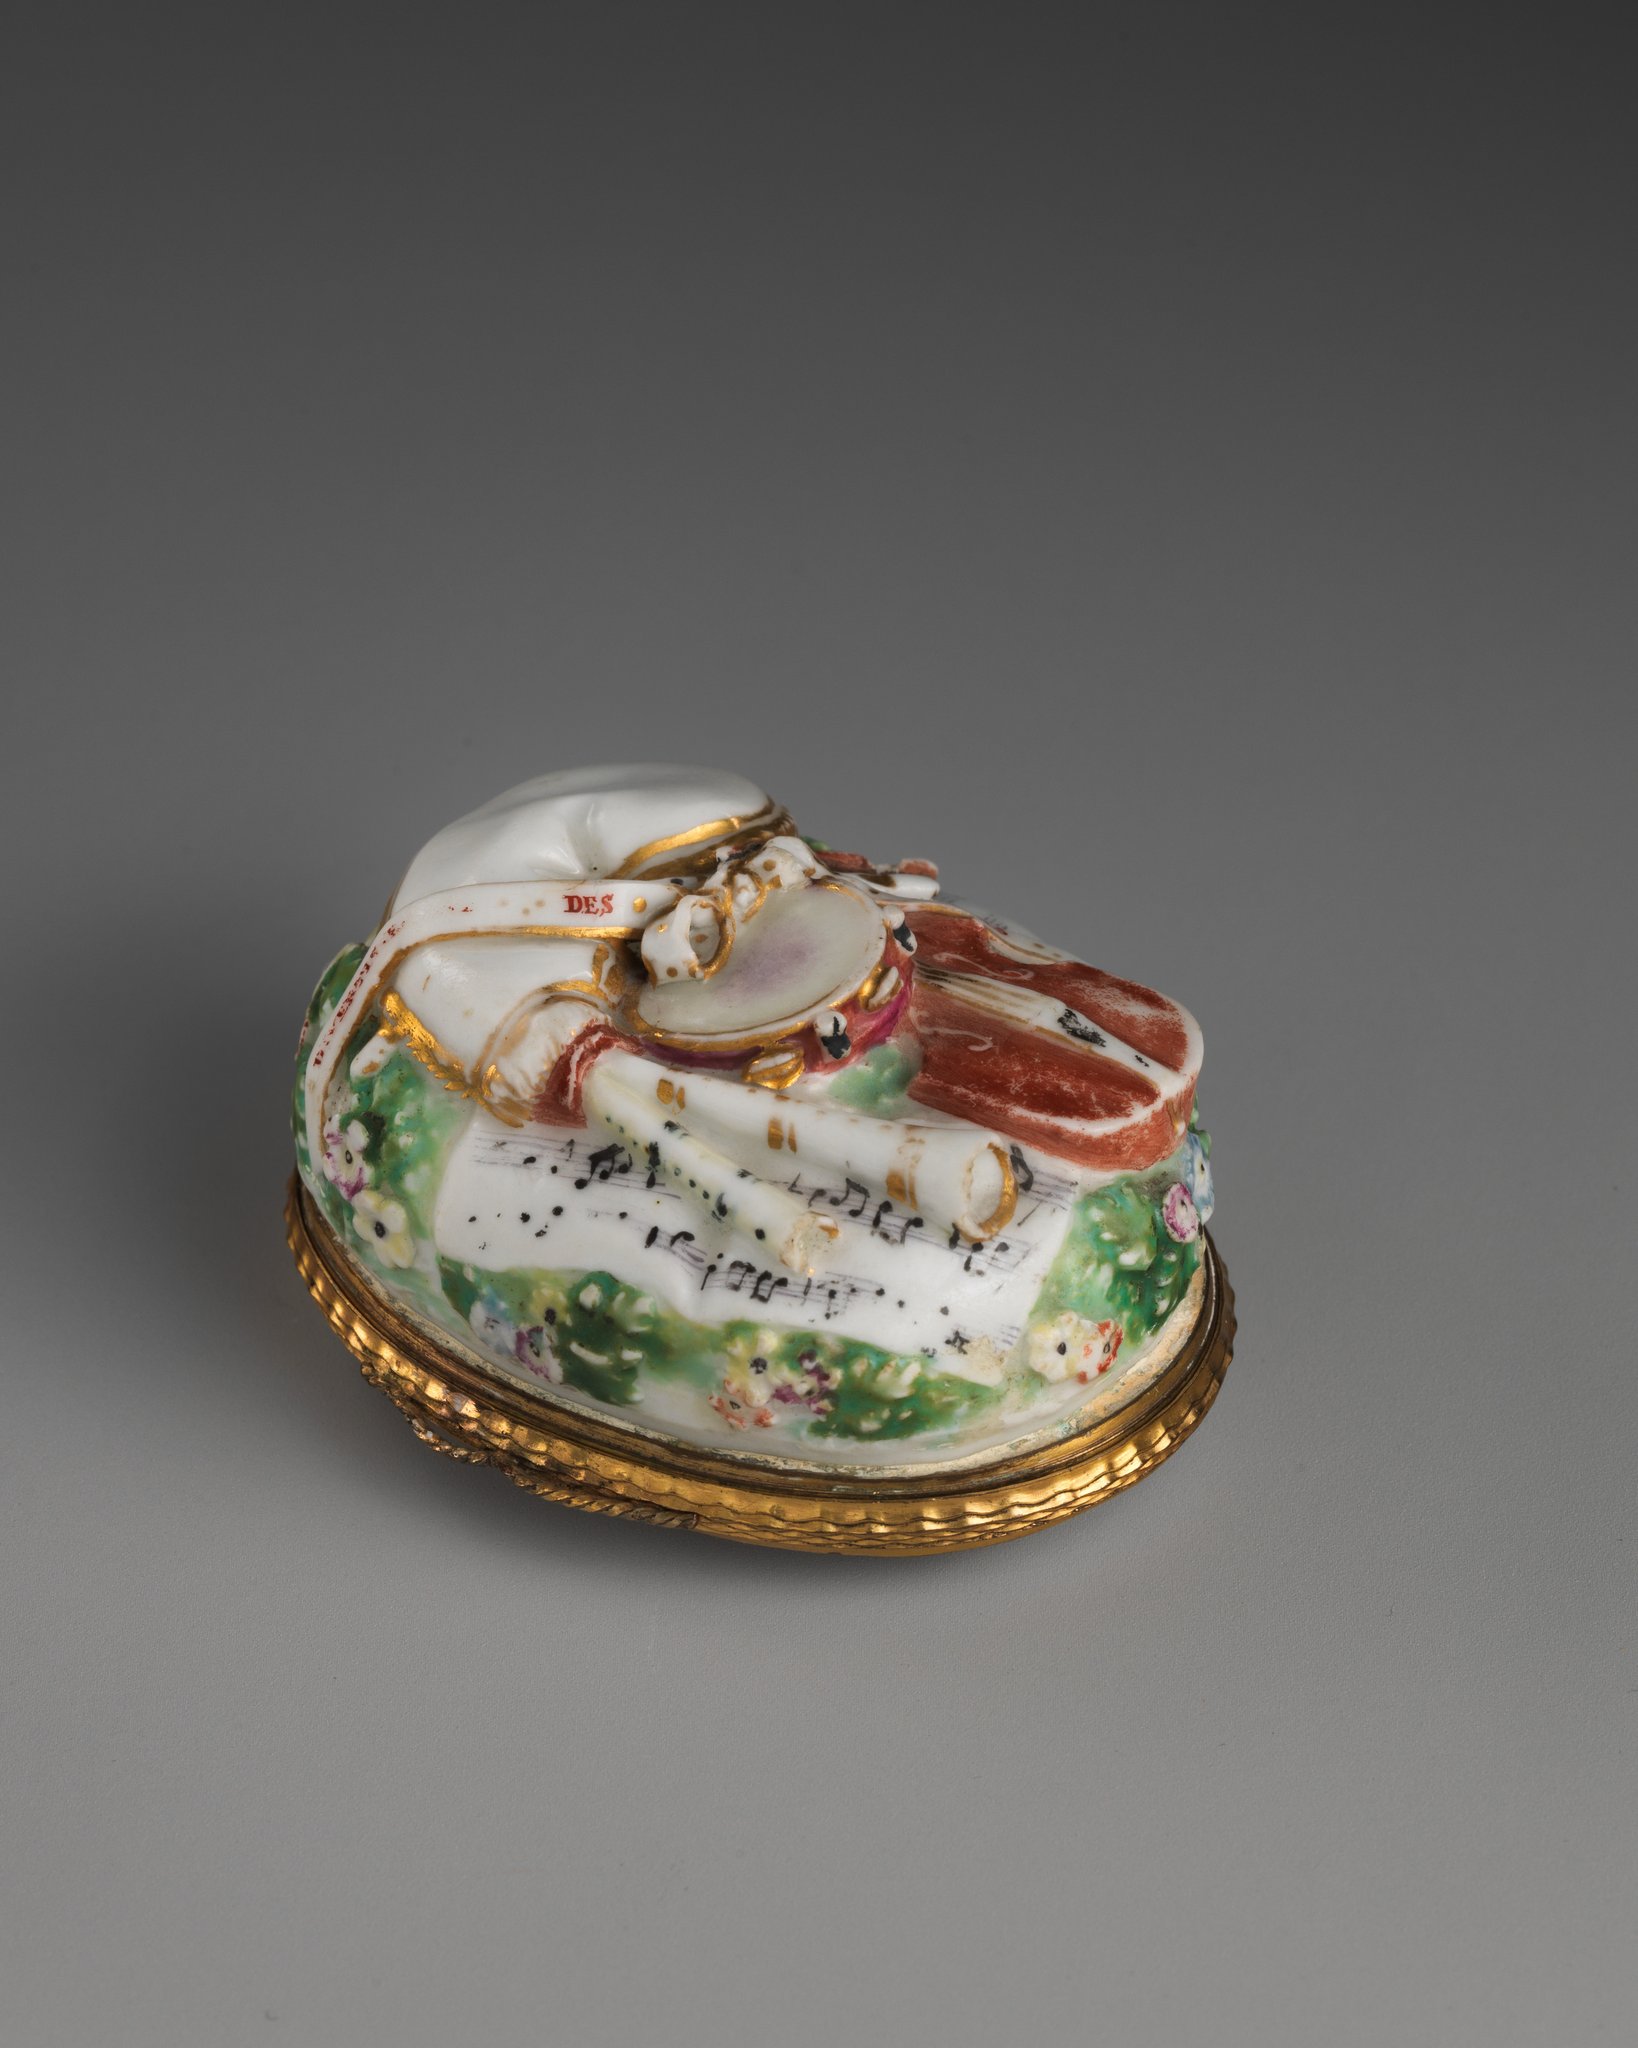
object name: toy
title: Musical instruments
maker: chelsea porcelain manufactory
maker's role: factory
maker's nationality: british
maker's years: 1744-1784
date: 1760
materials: soft paste porcelain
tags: bagpipes